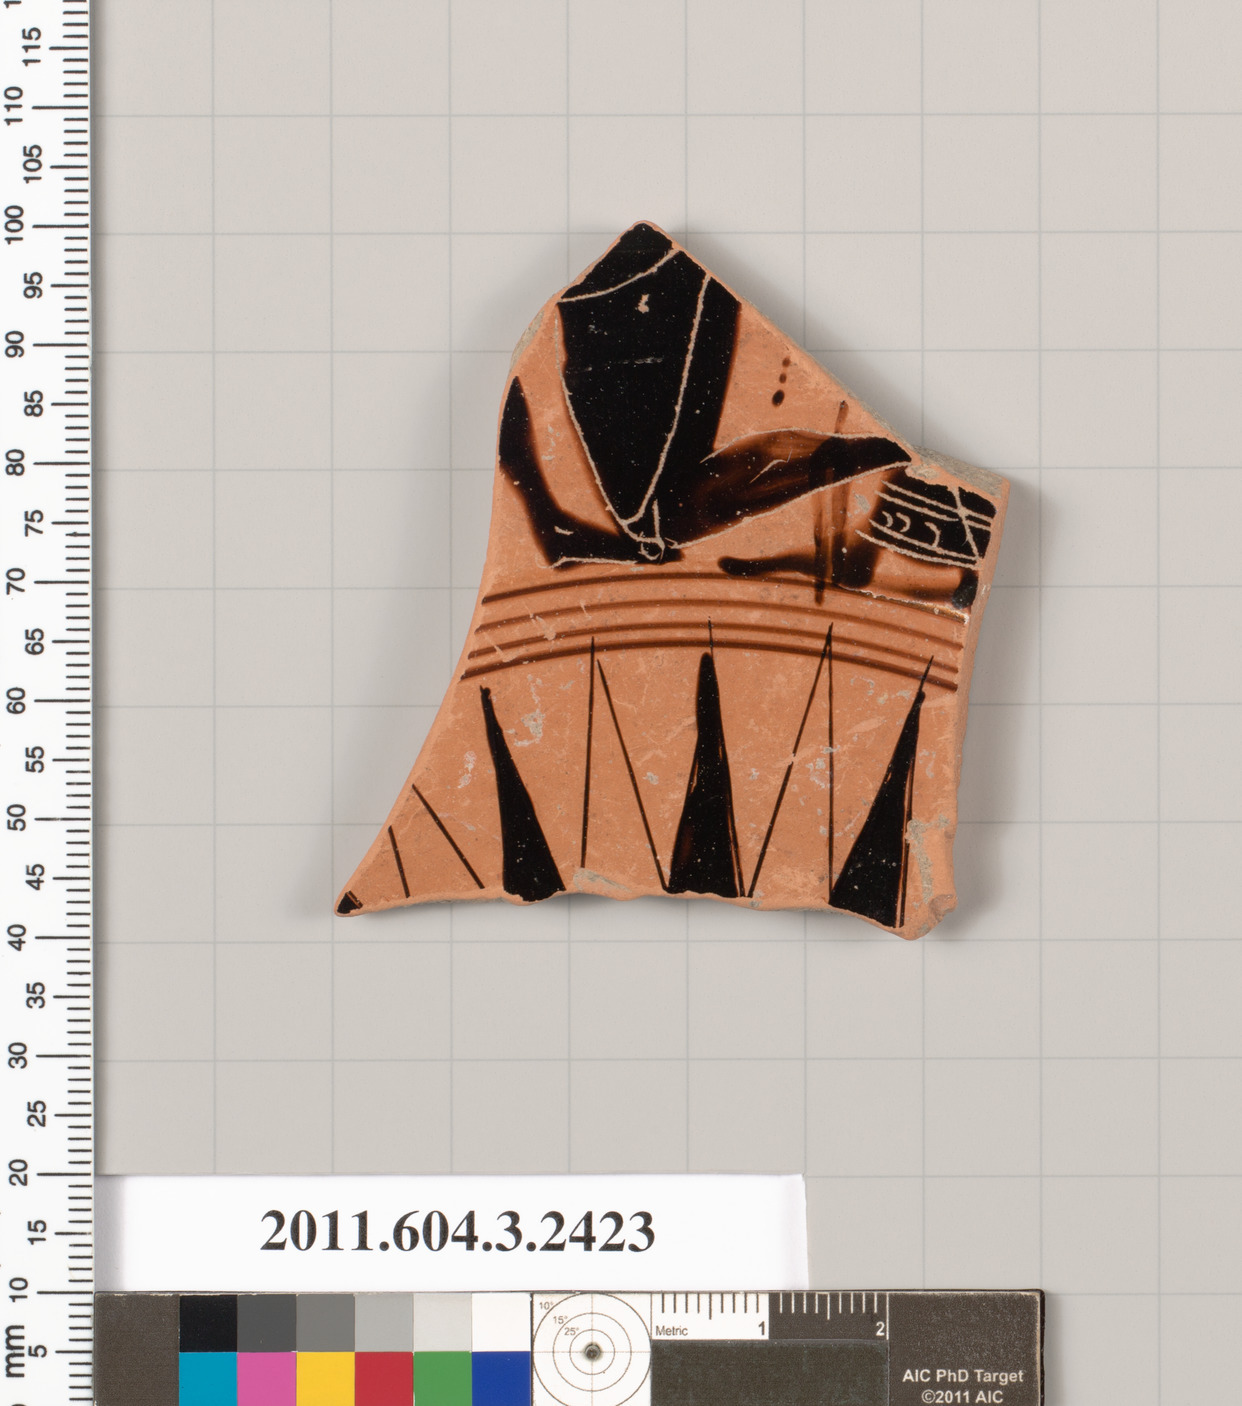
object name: kylix fragment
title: Terracotta fragment of a kylix: eye-cup (drinking cup)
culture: greek, attic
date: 530-520 BCE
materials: terracotta